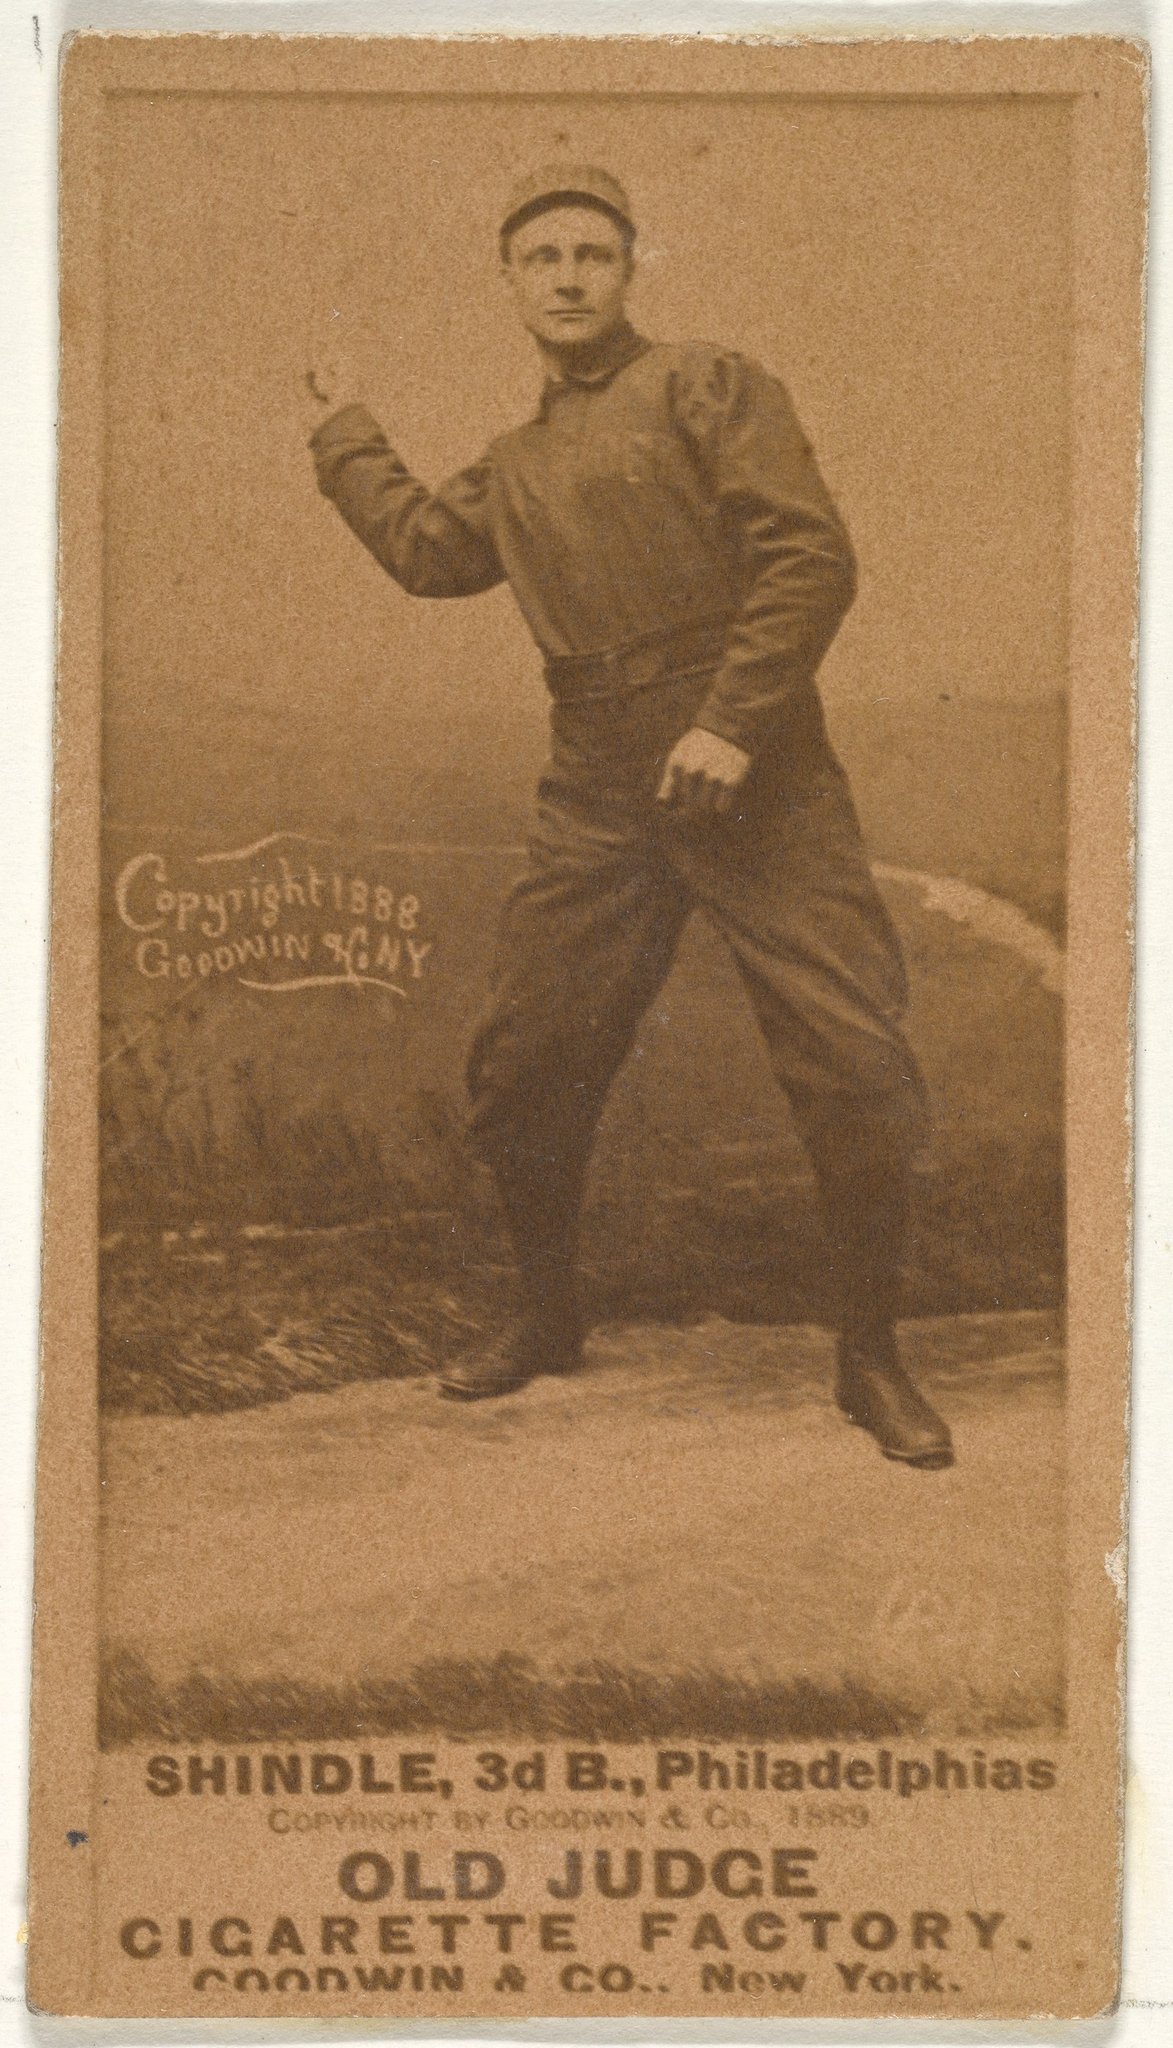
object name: baseball card, photograph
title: William D. "Billy" Shindle, 3rd Base, Philadelphia, from the Old Judge series (N172) for Old Judge Cigarettes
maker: goodwin & company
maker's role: publisher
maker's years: 1850-1950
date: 1889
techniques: albumen silver print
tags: men,portraits,baseball,athletes